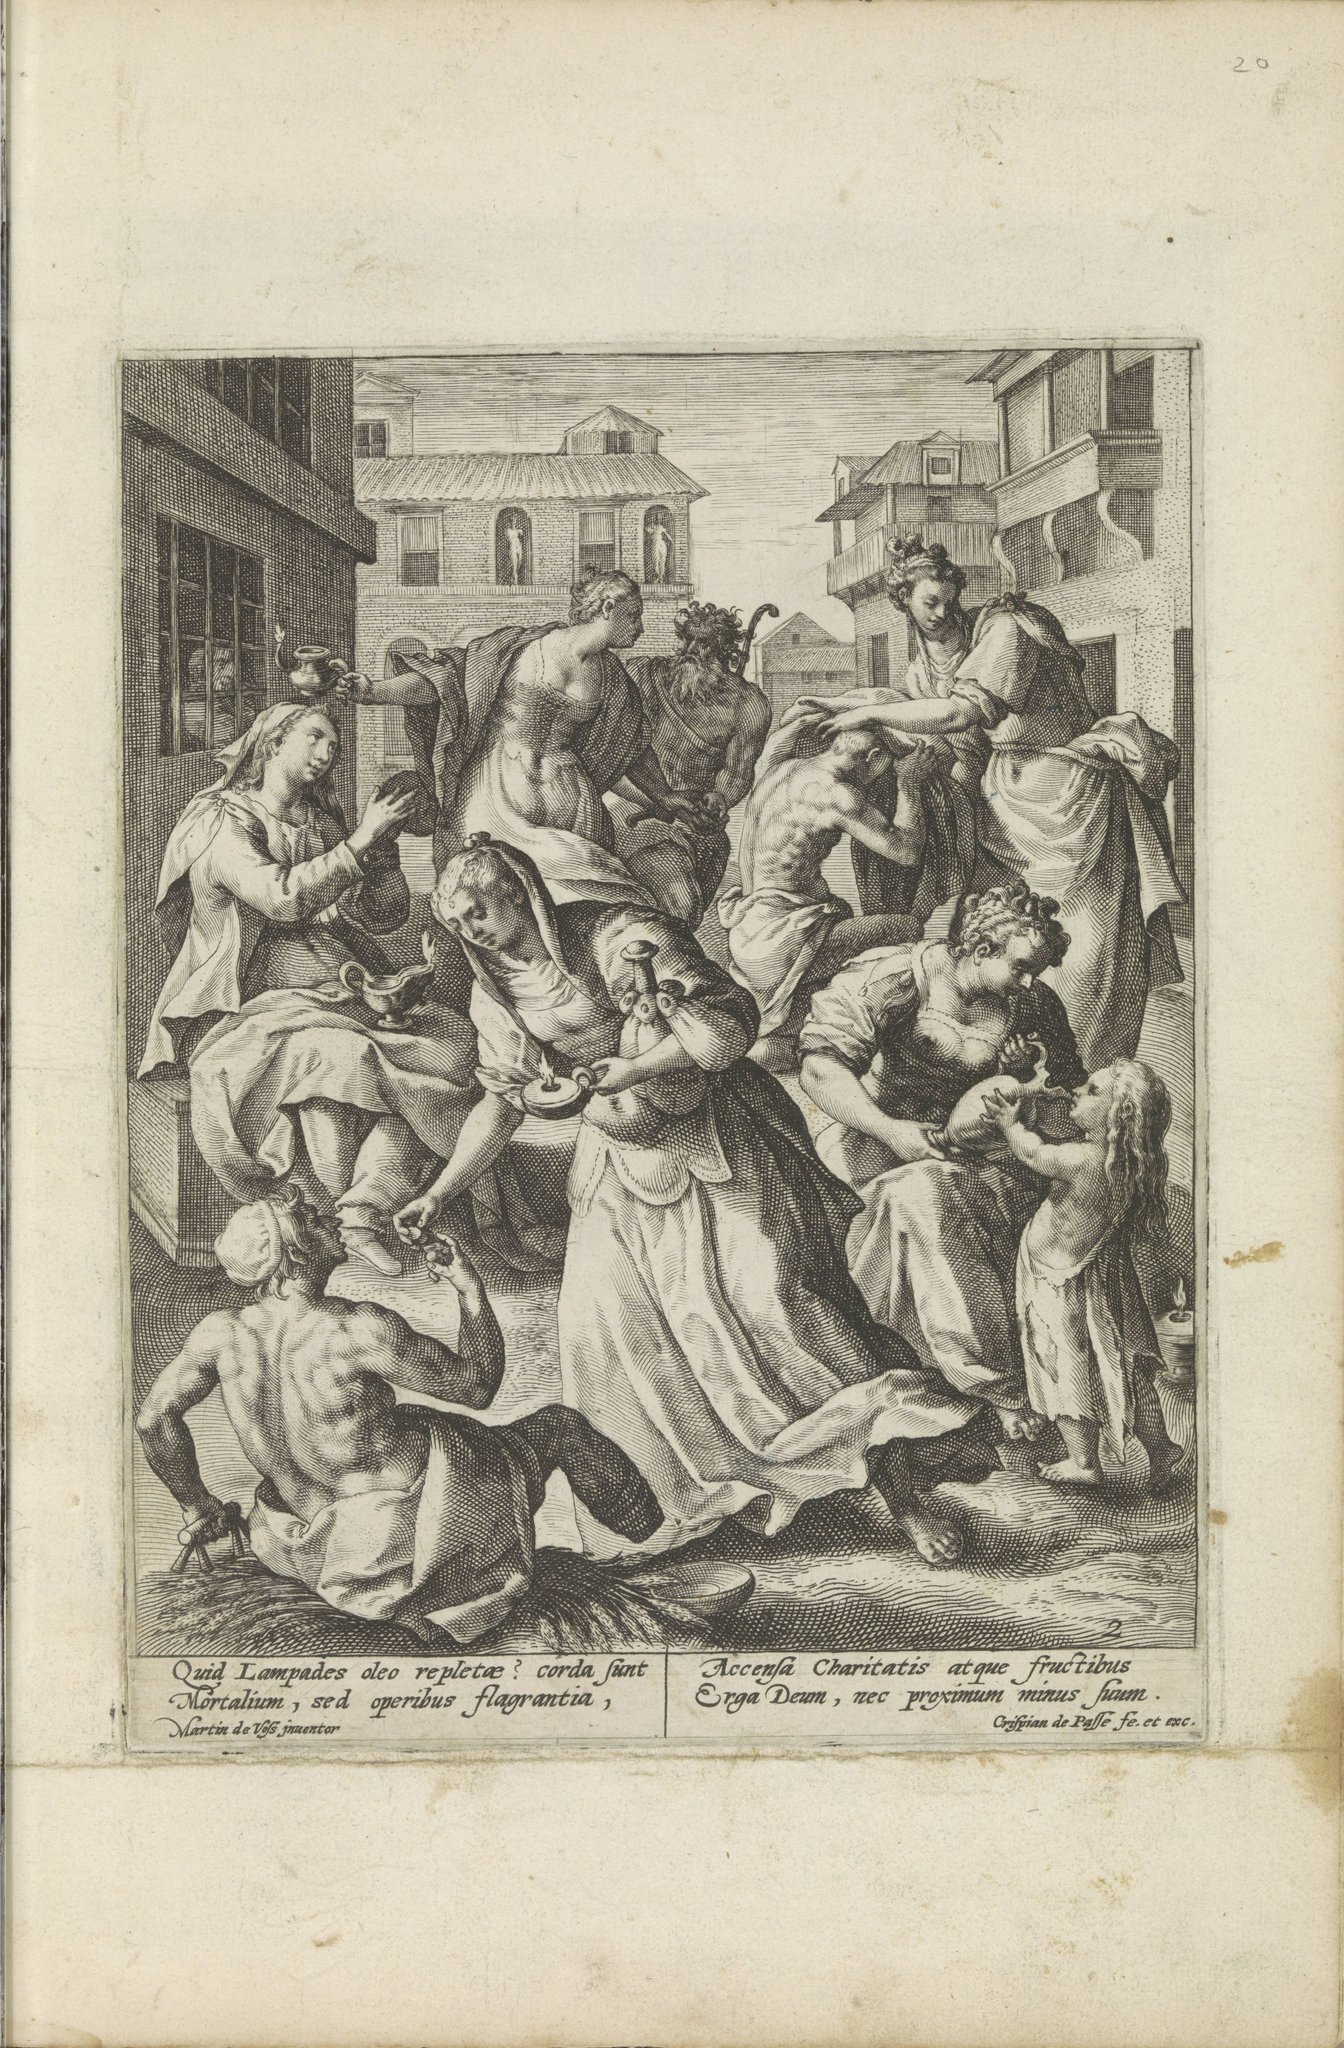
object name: album leaf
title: Parabola V. Virginvm Typis Aen: Expressa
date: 1589-1611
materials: paper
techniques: engraving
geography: cologne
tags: the wise and the foolish virgins ~ parable of christ (matthew 25:1-13), the (seven) acts of mercy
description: De vijf wijze maagden voeren werken van barmhartigheid uit (het bezoeken van een gevangene, het voeden van hongerigen en het laven van dorstigen, kleden van naakten en het herbergen van vreemdelingen). In de marge een vierregelig onderschrift, in twee kolommen, in het Latijn dat verwijst naar de deugdzaamheid van de vijf wijze maagden. Deze prent maakt deel uit van een album.